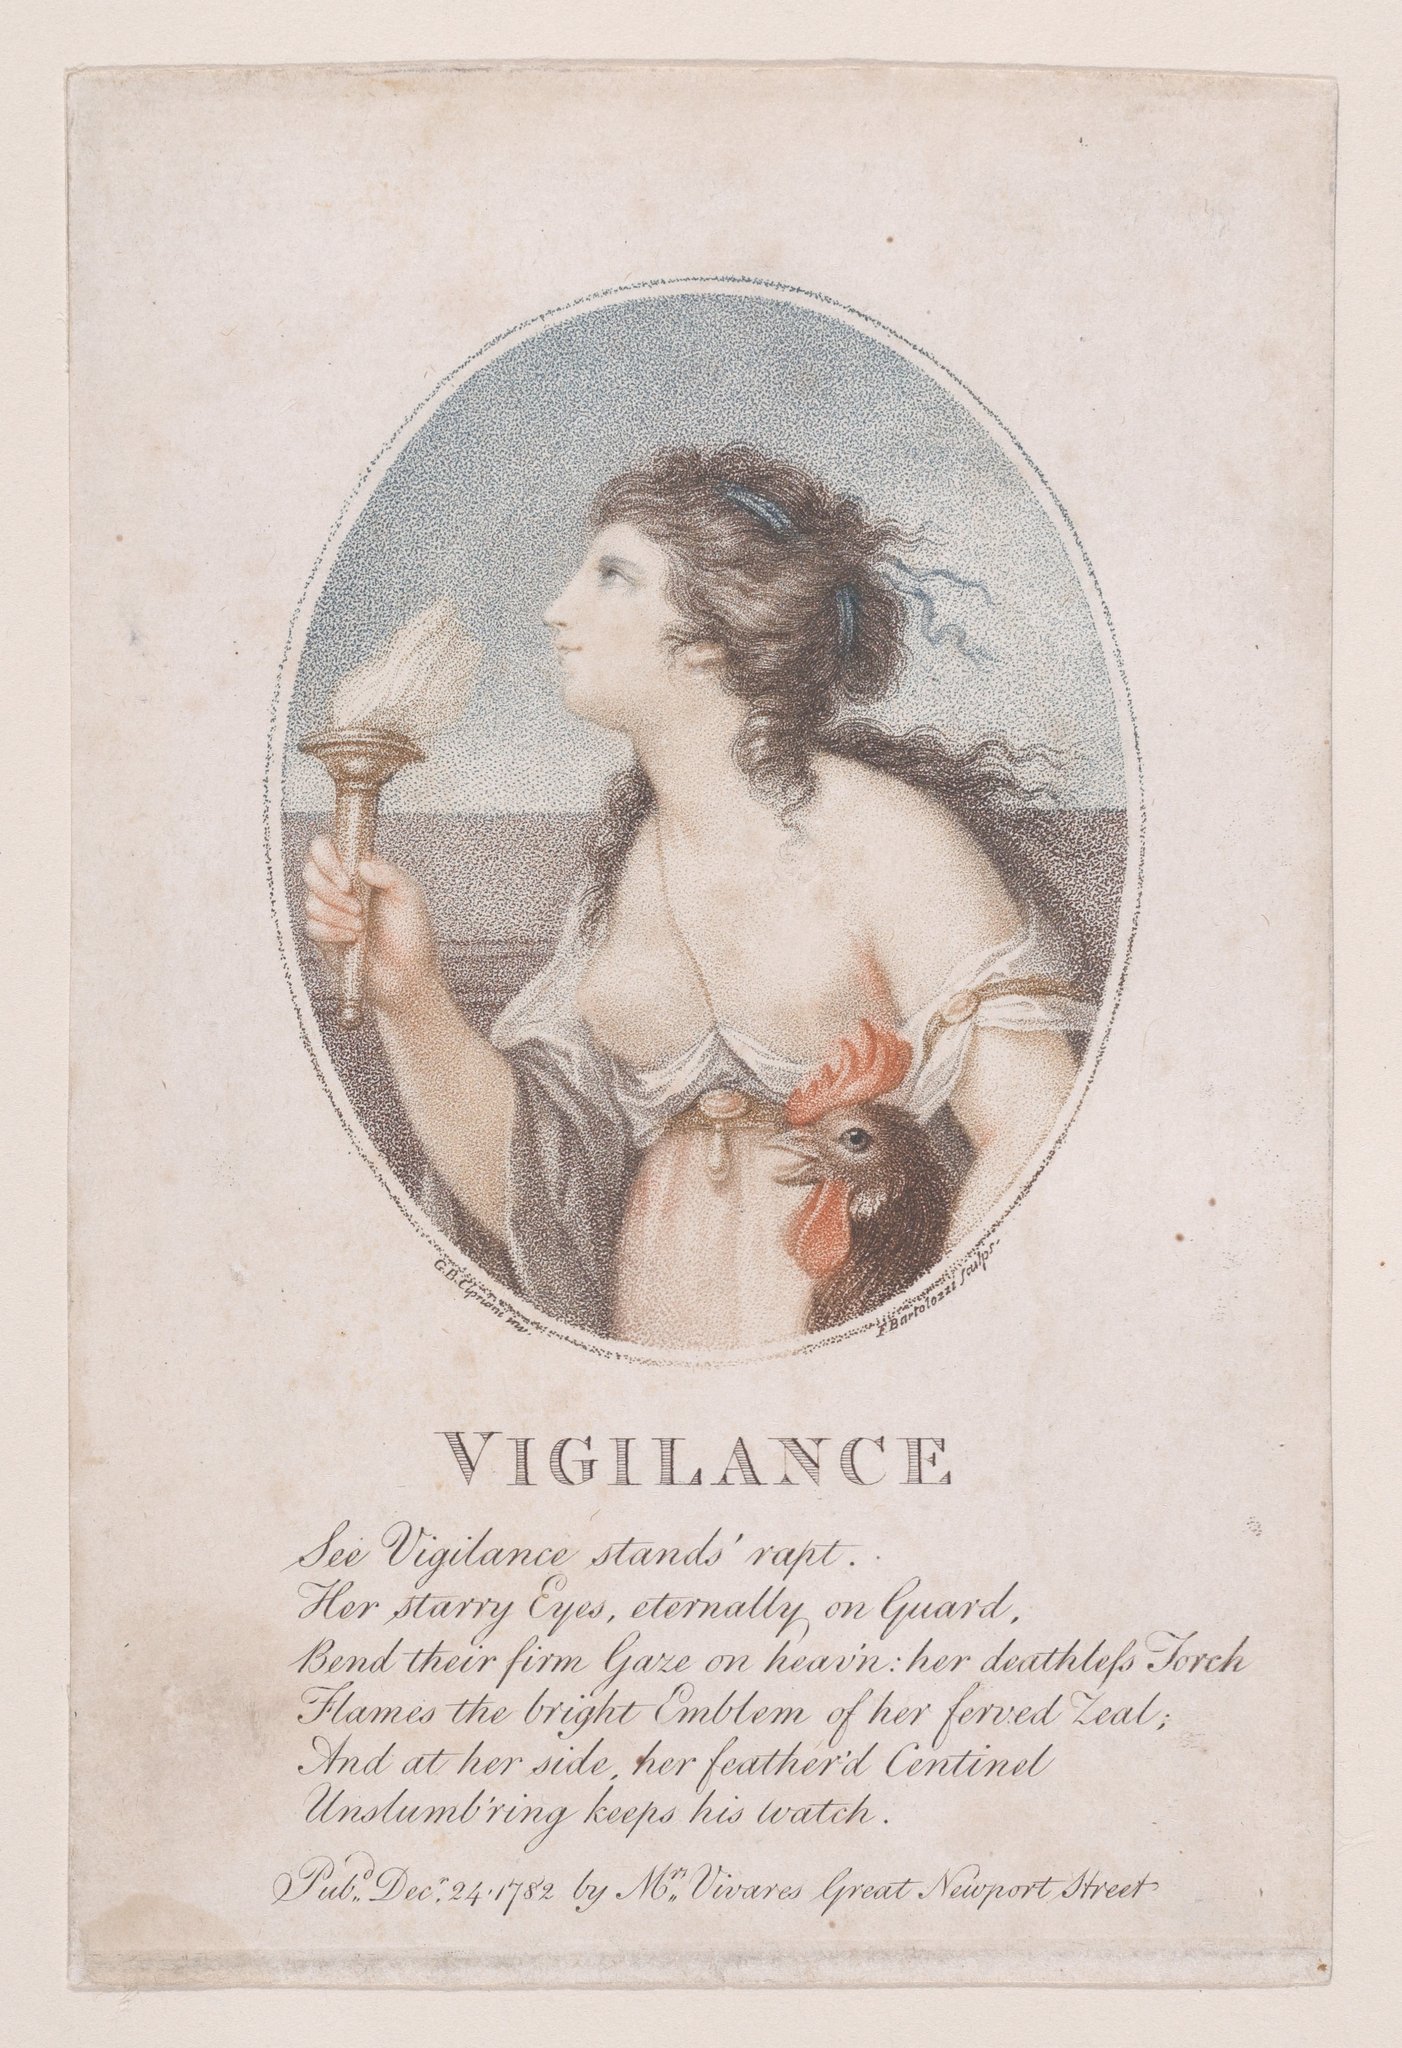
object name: print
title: Vigilance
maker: francesco bartolozzi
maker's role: artist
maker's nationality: italian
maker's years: 1728-1815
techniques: etching, printing, engraving